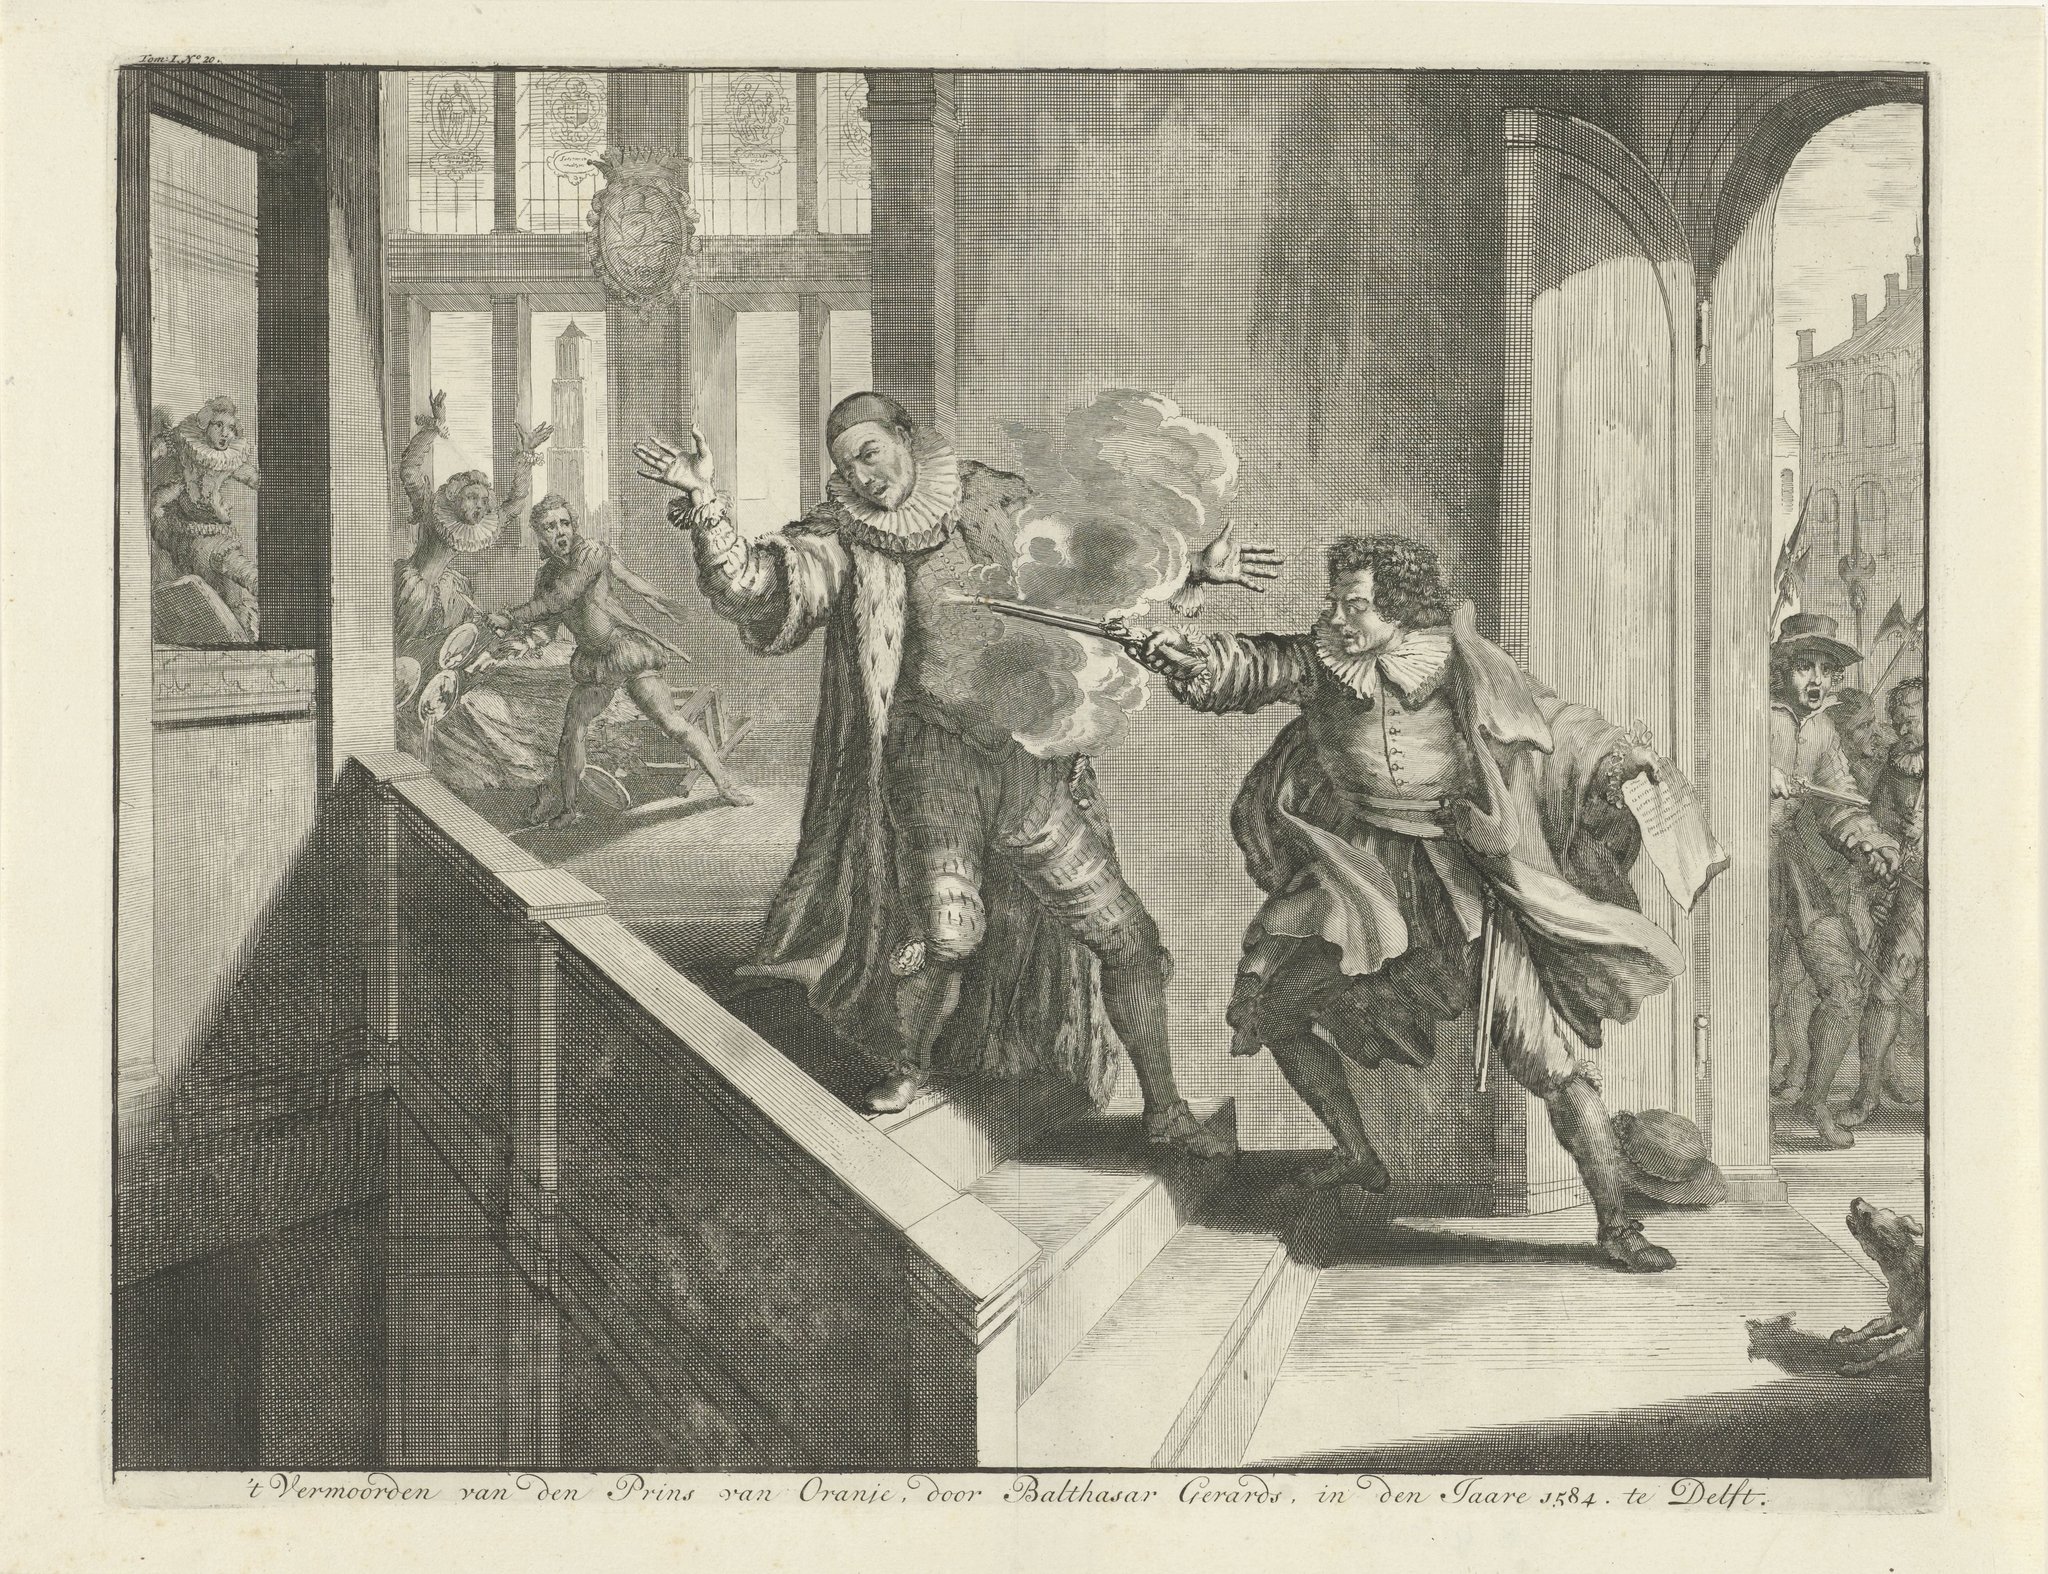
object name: book illustration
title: Moord op de prins van Oranje, 1584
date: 1730-1738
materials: paper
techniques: engraving, etching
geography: amsterdam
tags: delft, william i (prince of orange), attempt, political murder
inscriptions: collector's mark: Lugt 2228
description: De prins van Oranje te Delft vermoord door Balthasar Gerards, 10 juli 1584. Willem van Oranje wordt op een trap bij de openstaande deur neergeschoten door Balthasar Gerards. Prent linksboven gemerkt: Tom: I. No. 20.